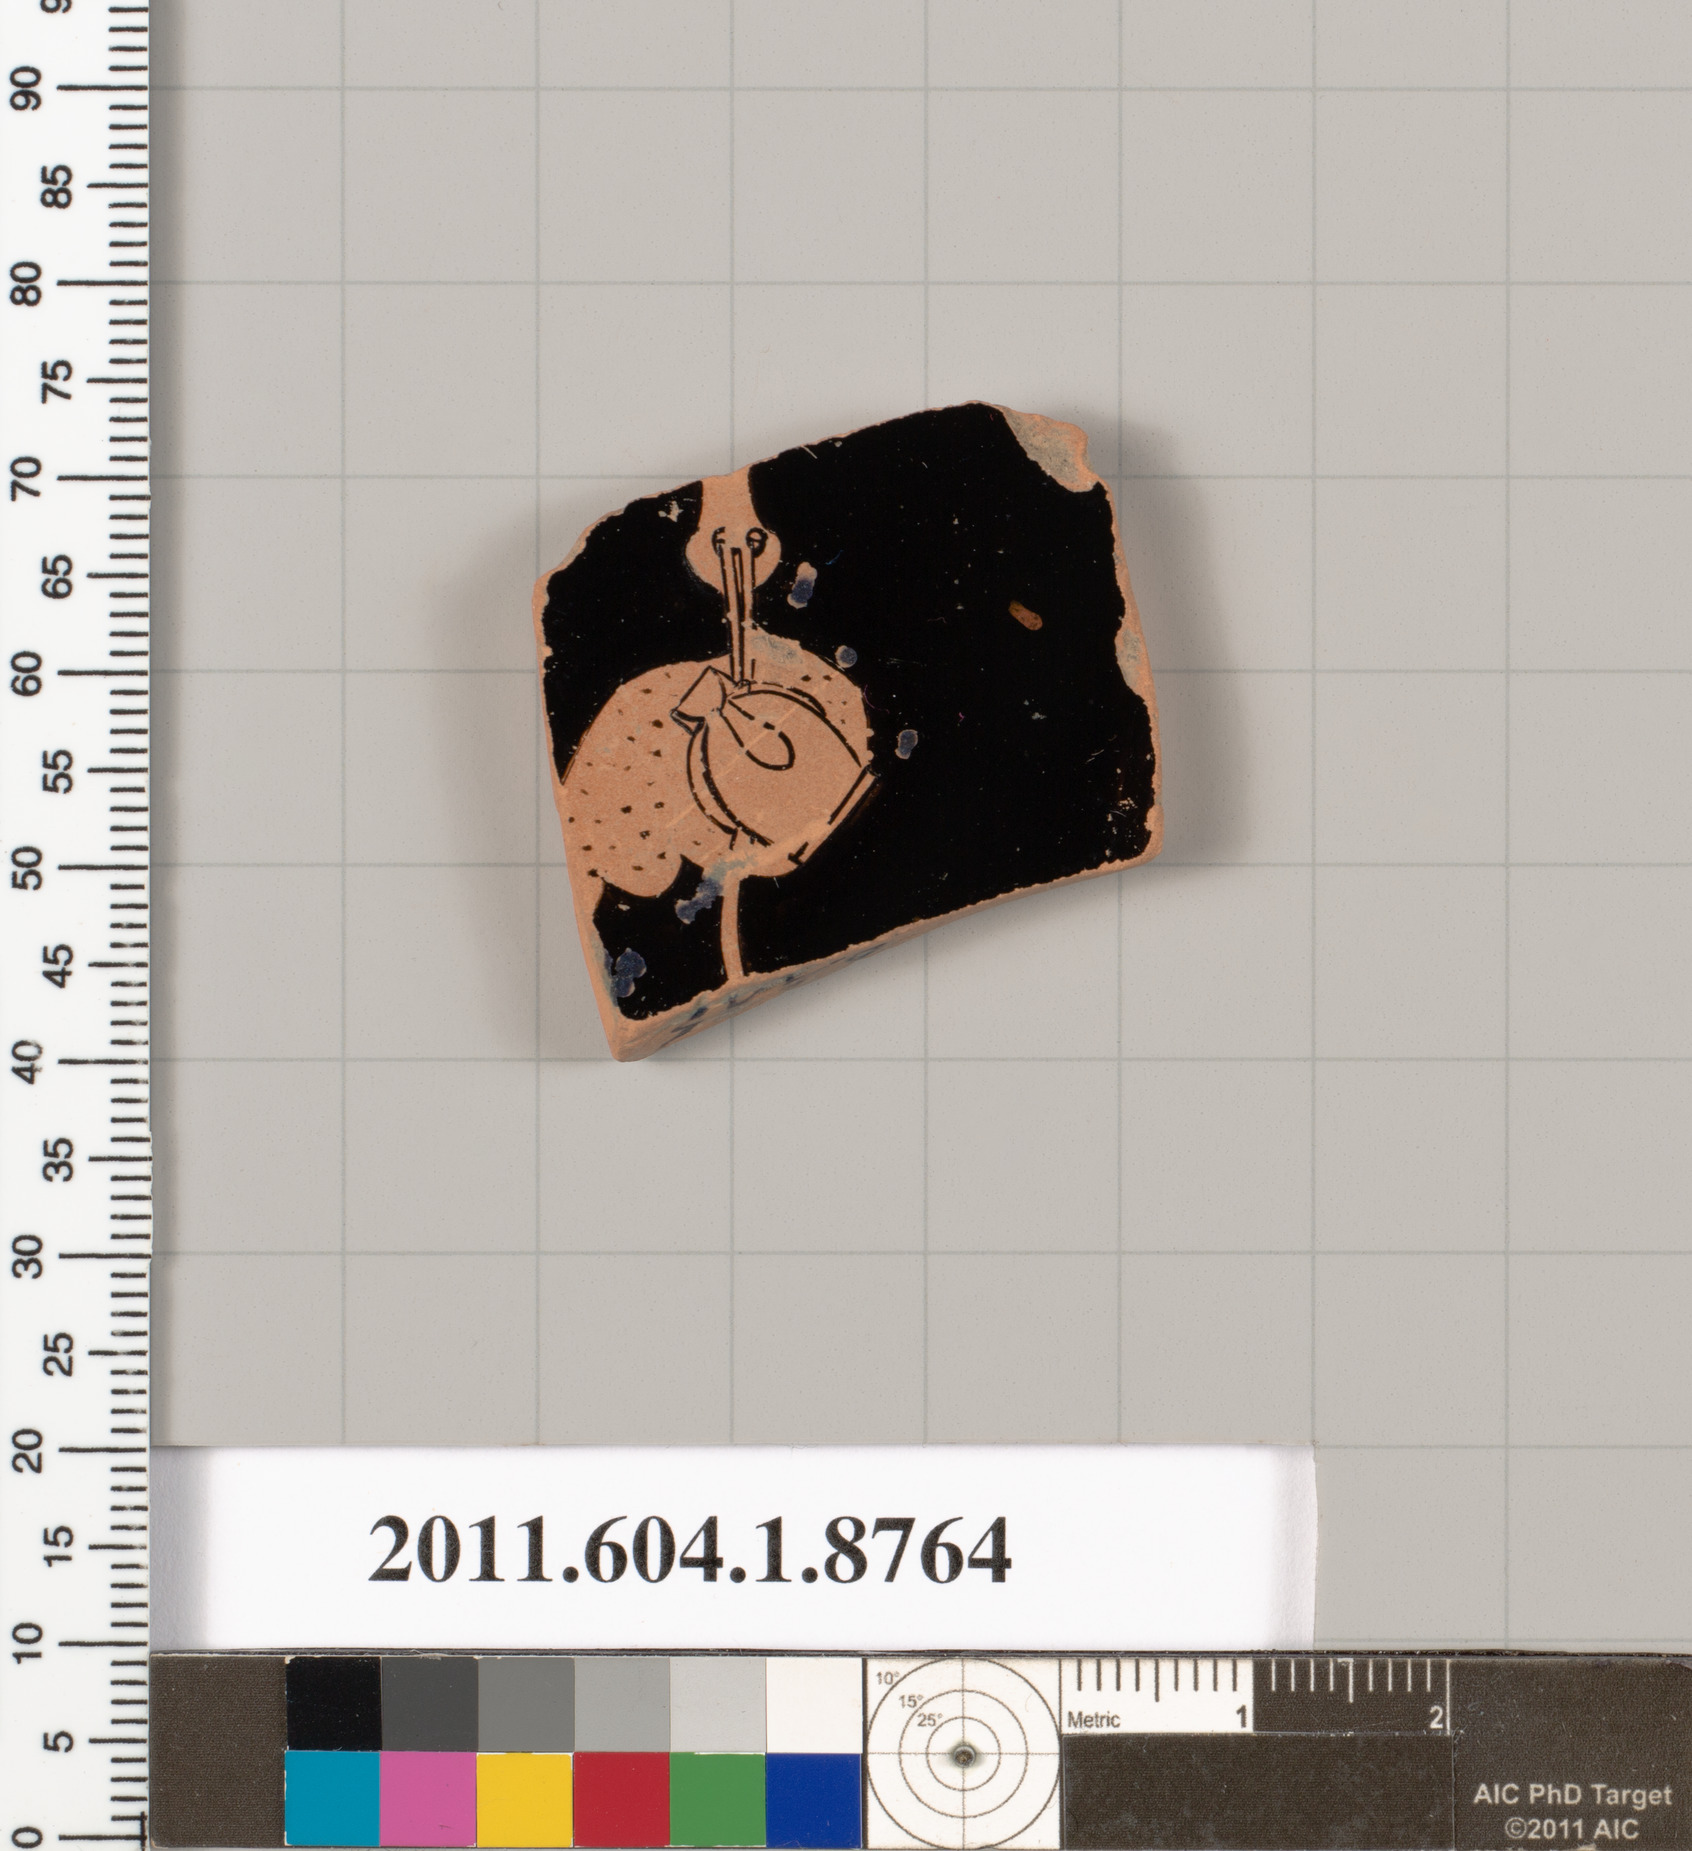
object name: kylix fragment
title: Terracotta fragment of a kylix (drinking cup)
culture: greek, attic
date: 500-480 BCE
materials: terracotta